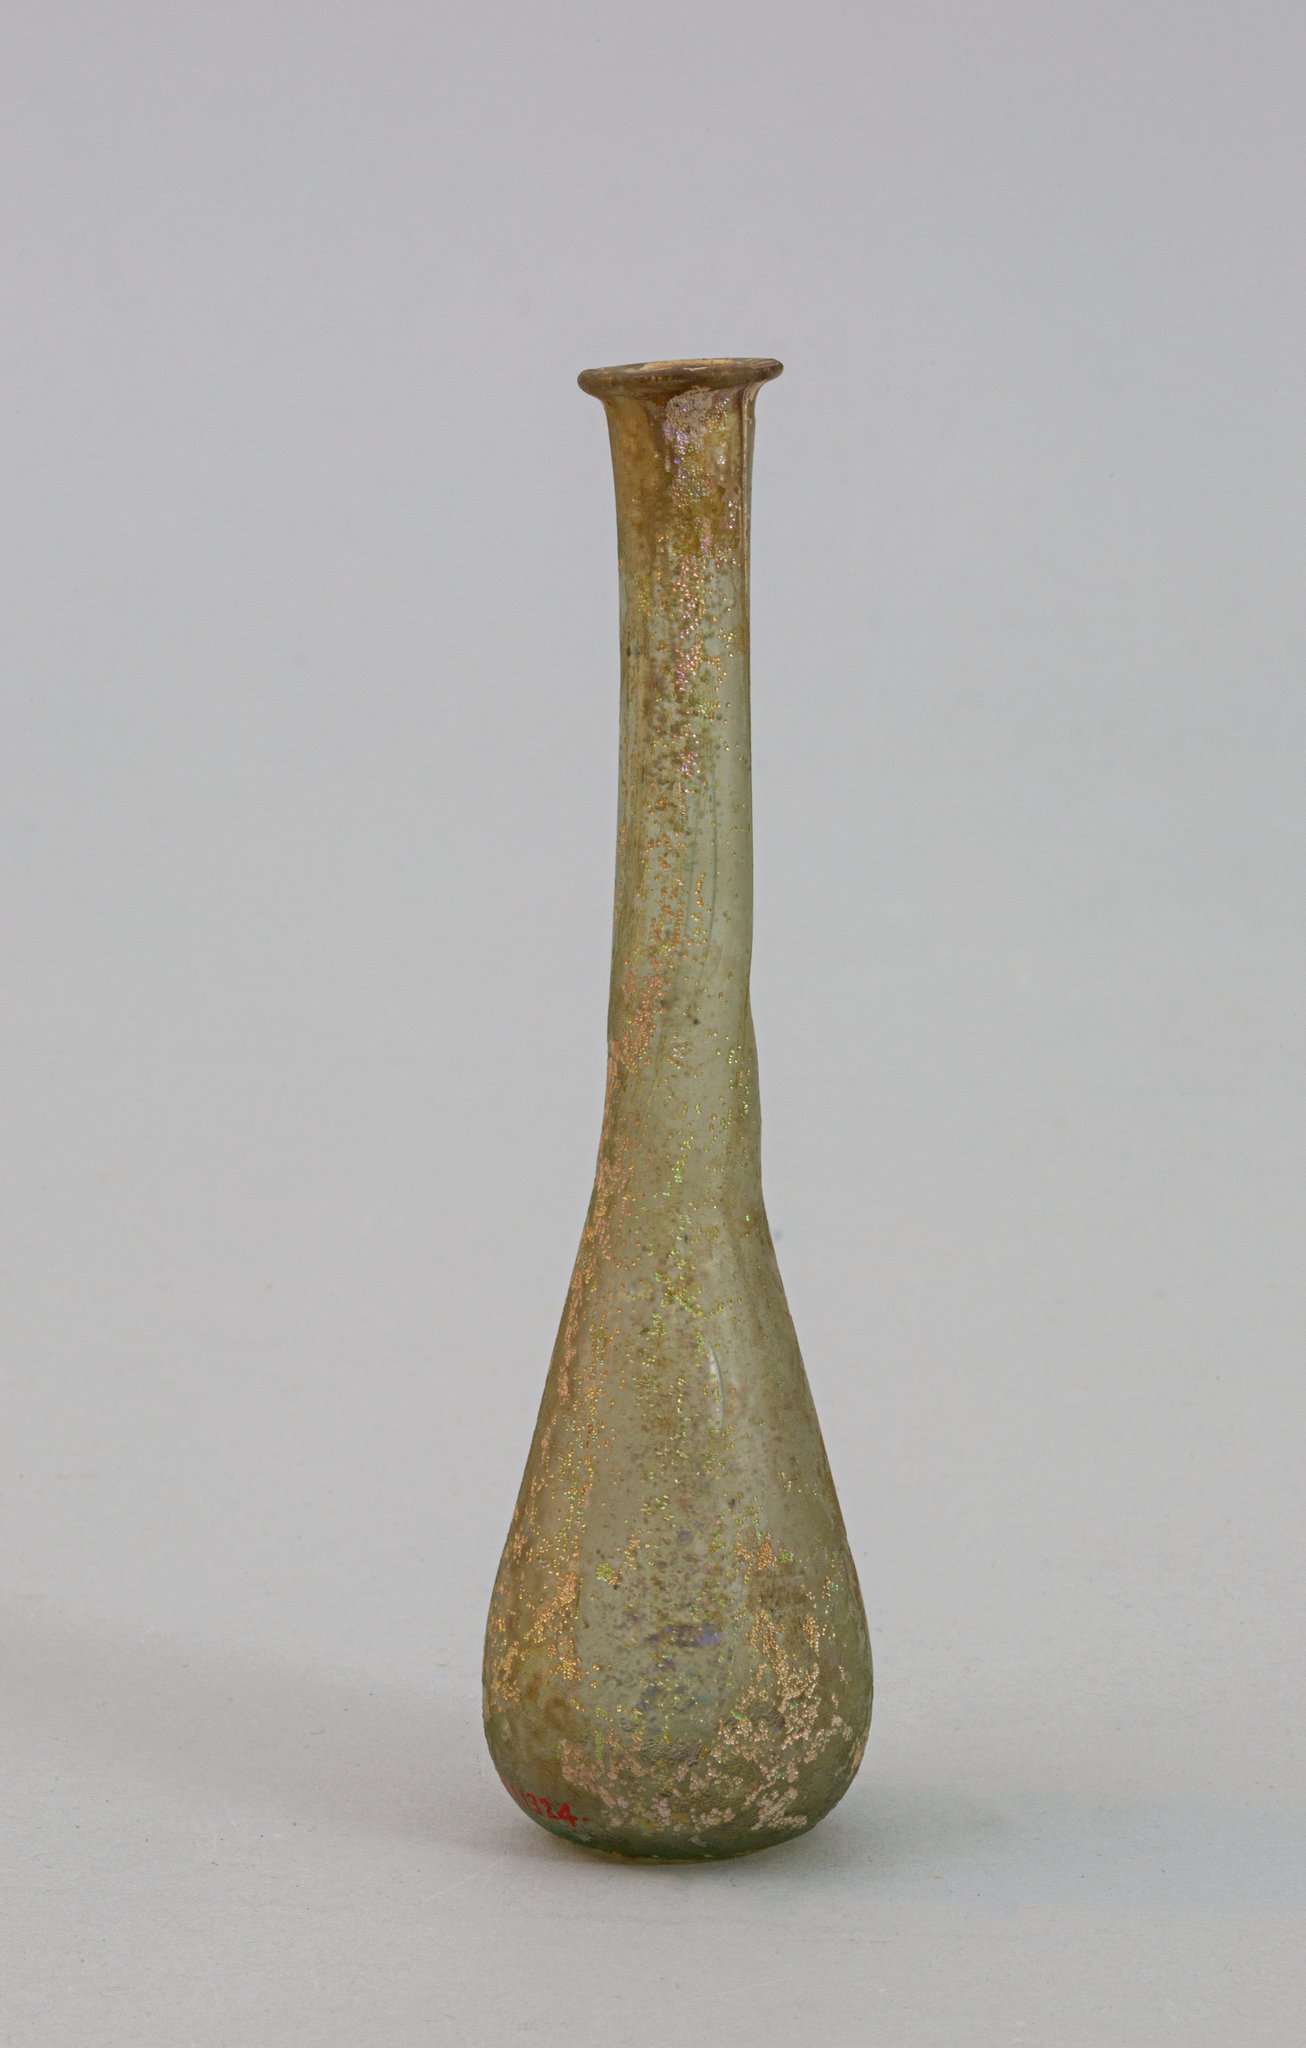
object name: perfume bottle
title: Glass perfume bottle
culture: roman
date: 67-300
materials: glass